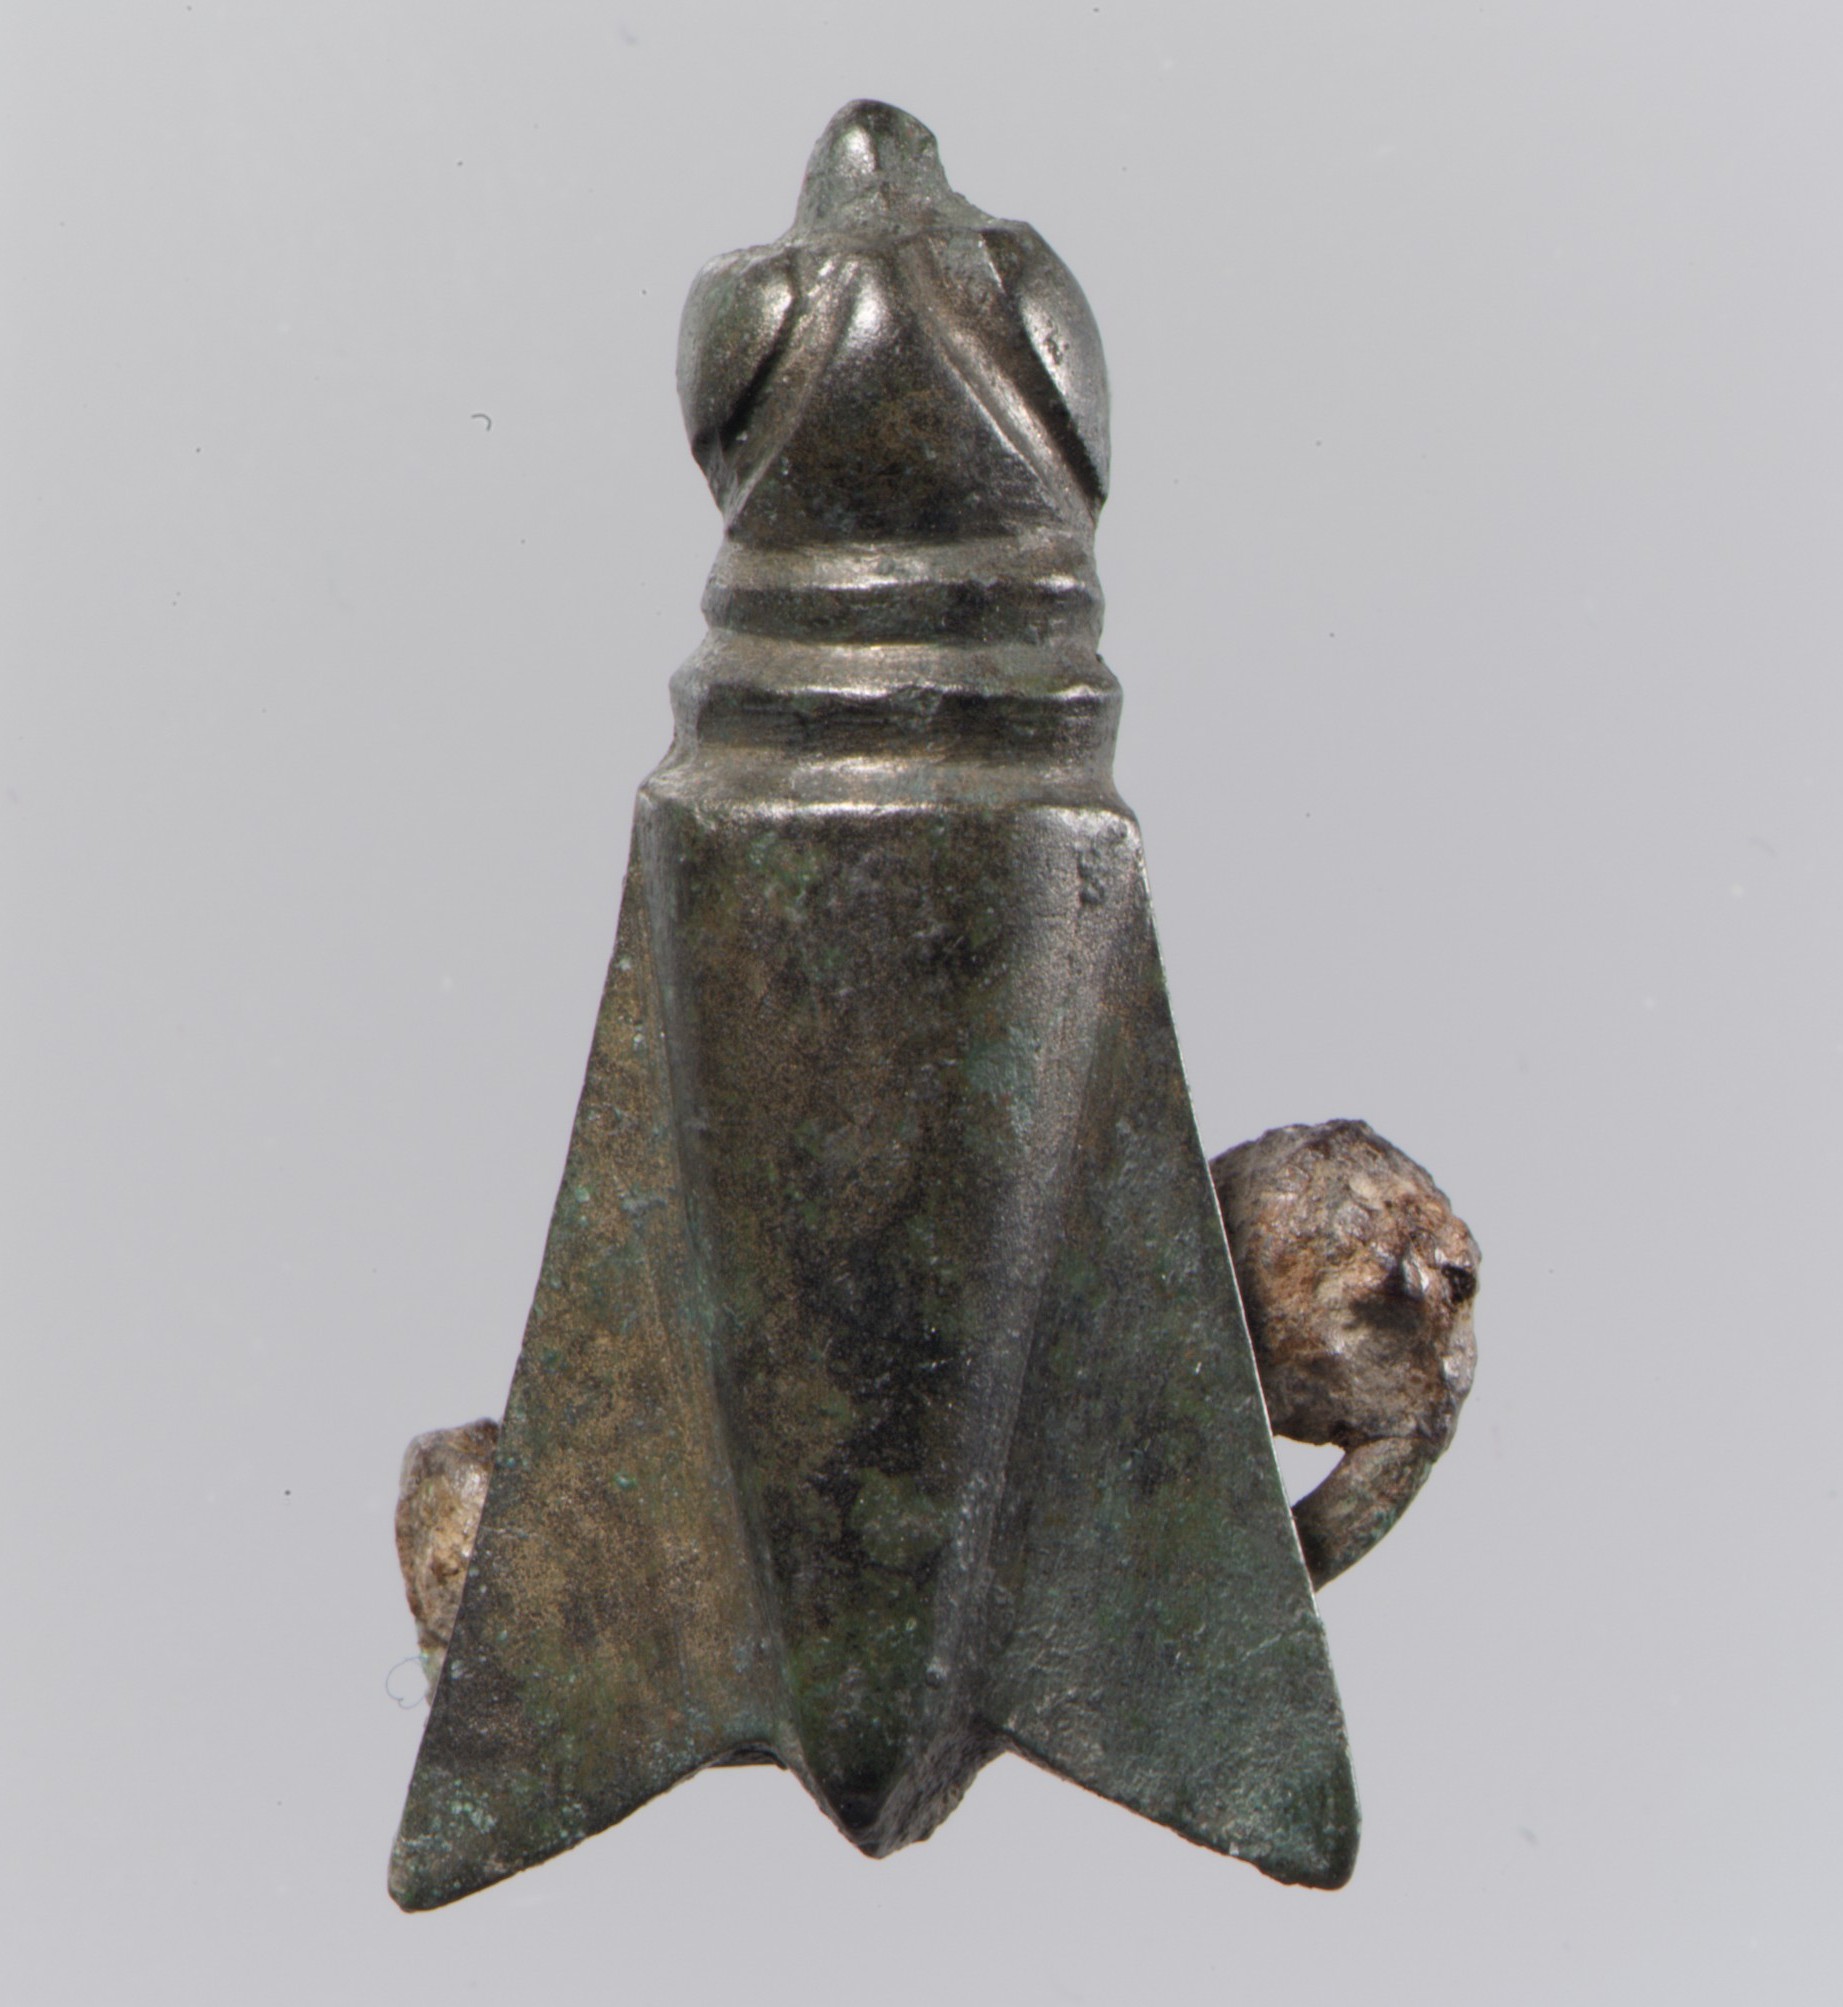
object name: brooch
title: Brooch in the Form of a Cicada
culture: east germanic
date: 350-450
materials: copper alloy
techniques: casting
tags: insects